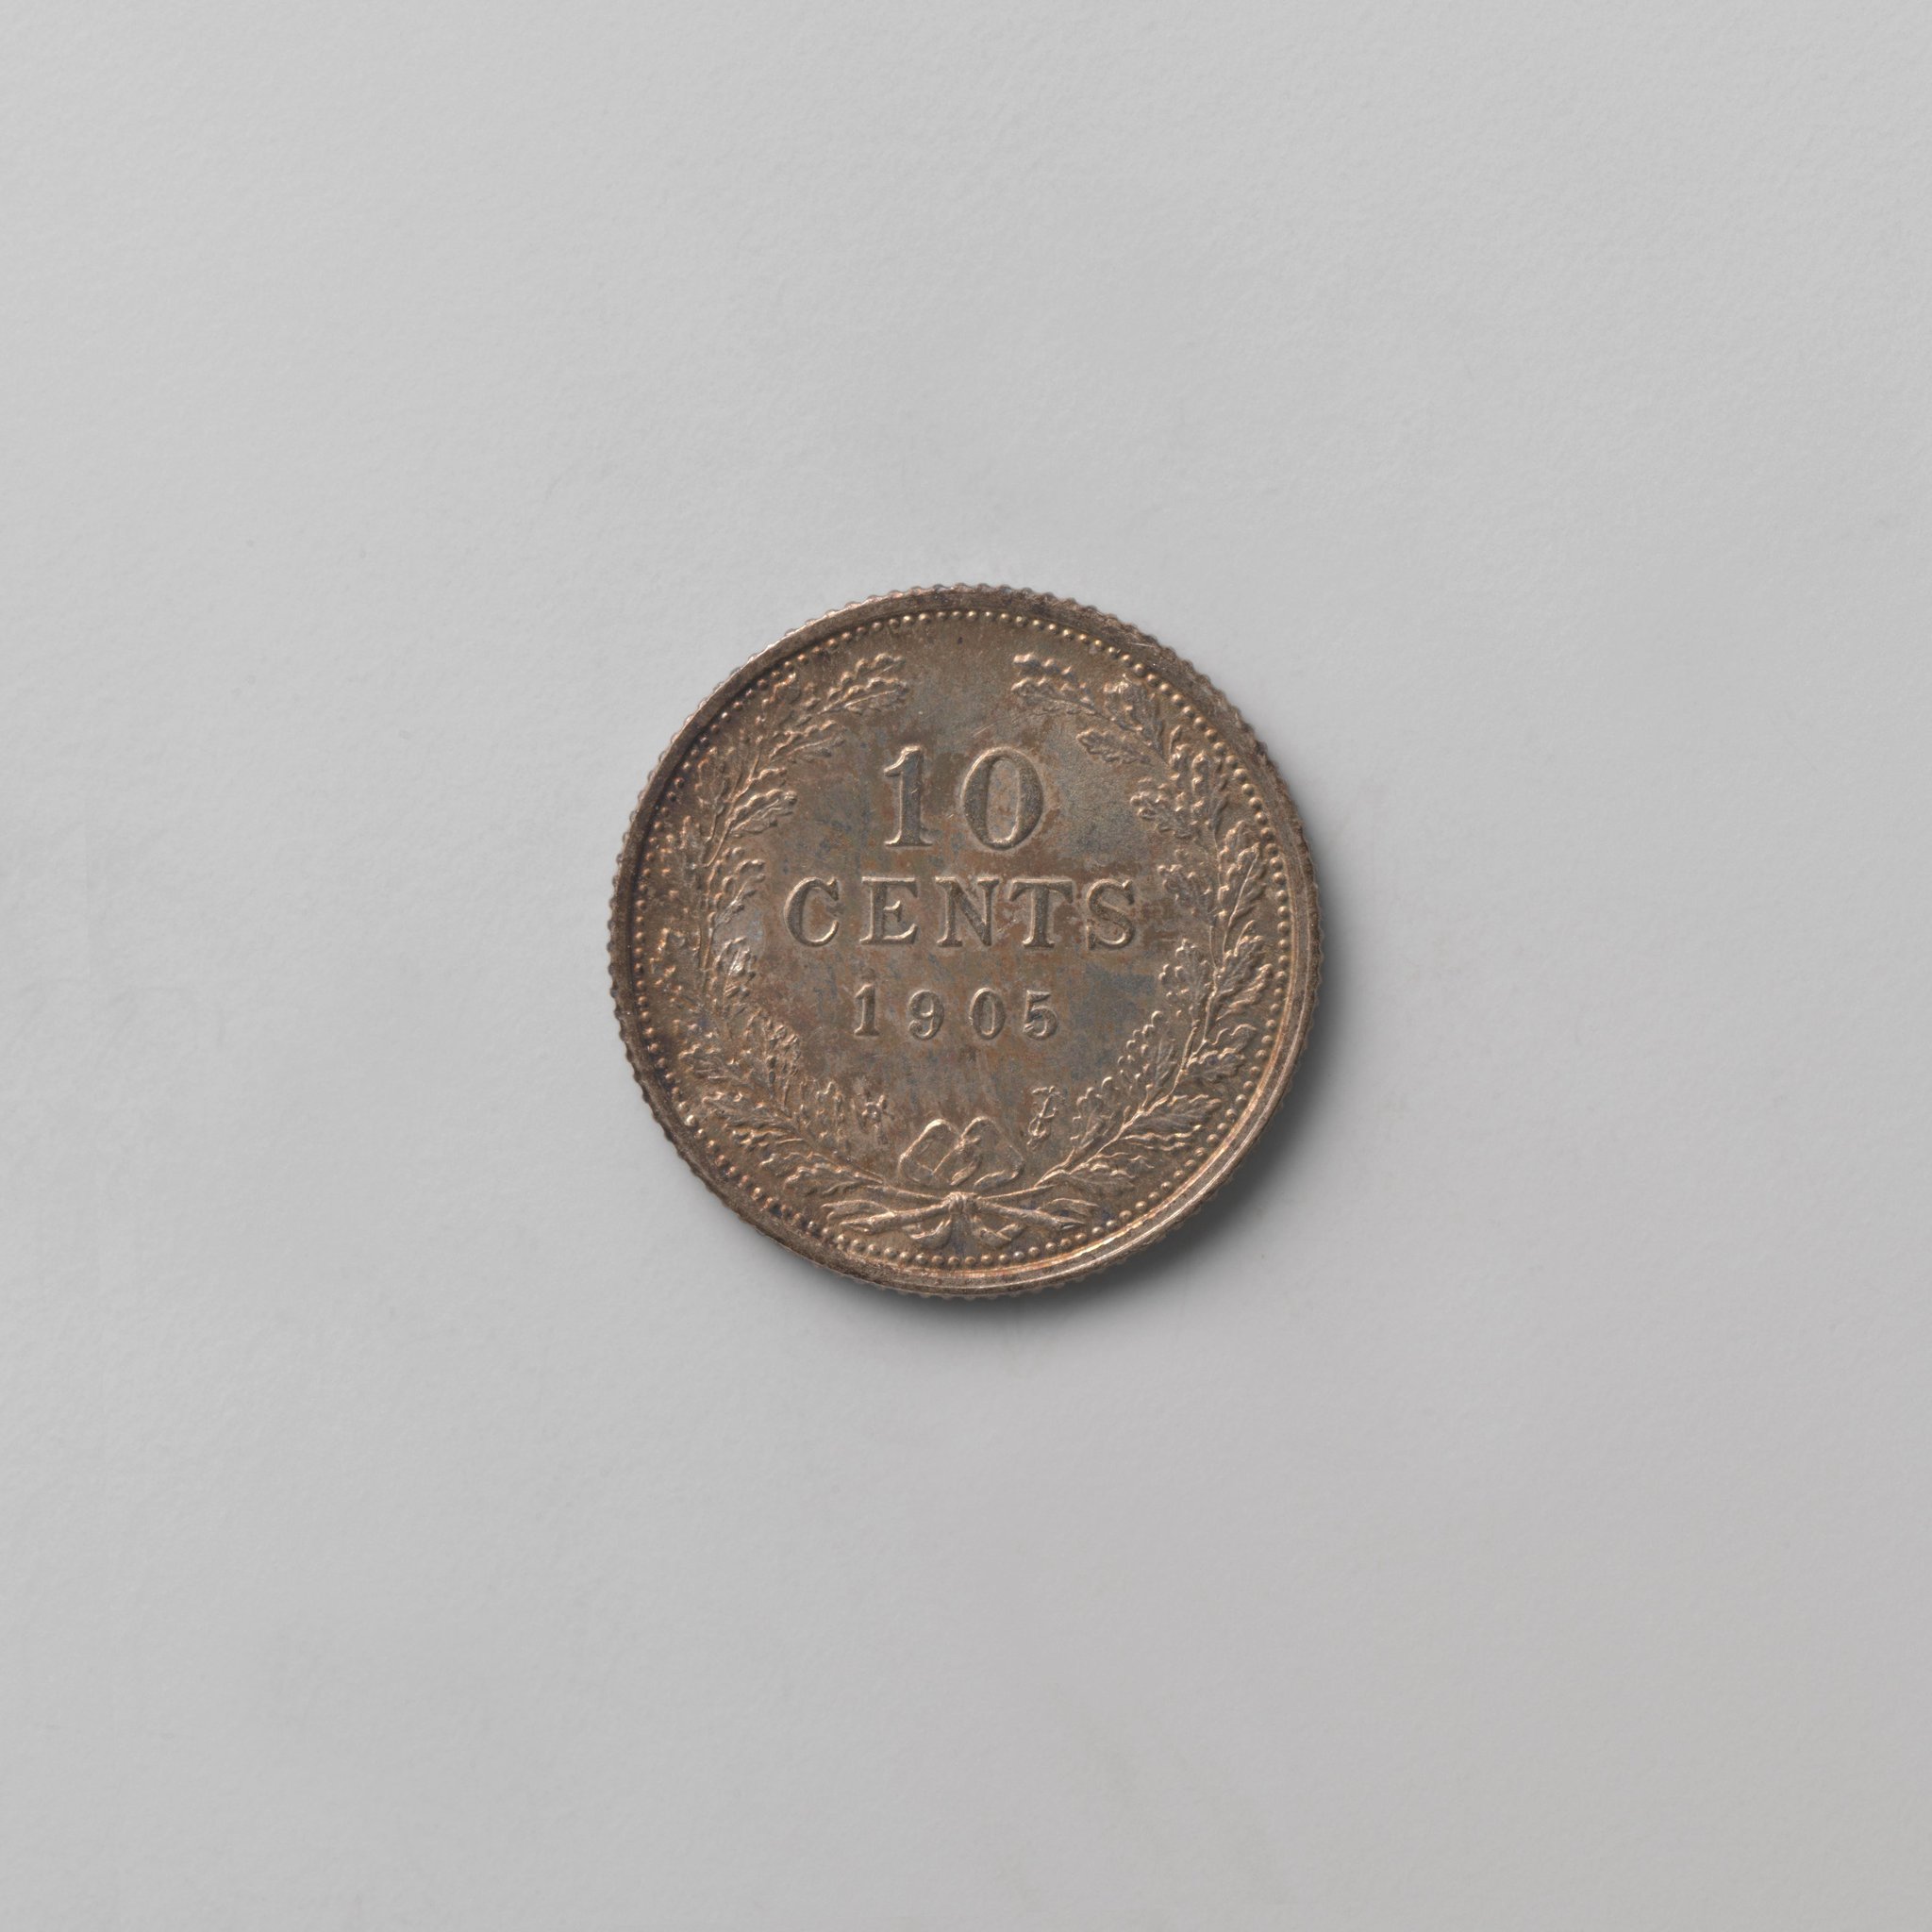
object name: coin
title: Nederland,10 cent,1905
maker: wilhelmina of the netherlands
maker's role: print maker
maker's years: 1880-1962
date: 1905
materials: silver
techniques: striking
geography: utrecht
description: Zilveren munt. Voorzijde: hoofd met diadeem naar links. Keerzijde: binnen twee samengebonden eiketakken waarde-aanduiding 10 cents en jaartal. Kartelrand.